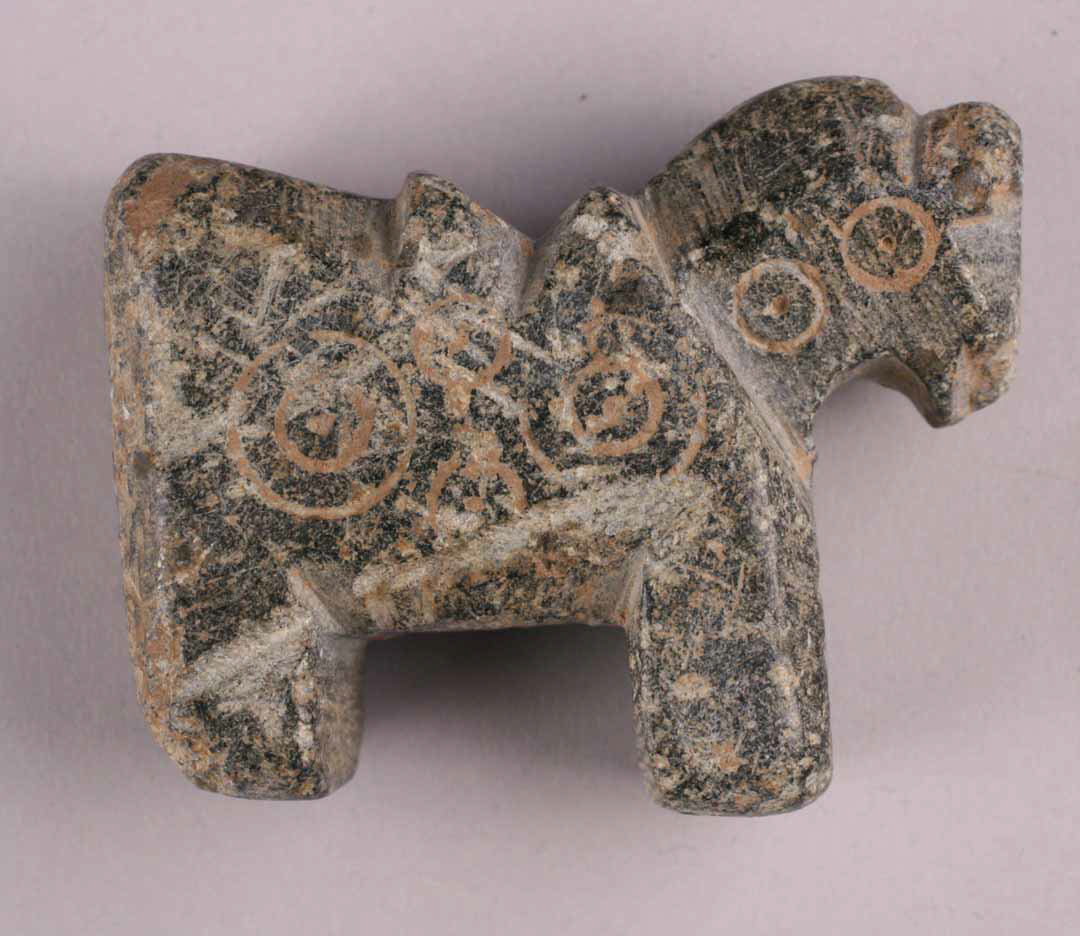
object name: stand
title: Stand for a Spit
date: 701-1200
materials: stone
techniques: carving, incising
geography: iran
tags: horses